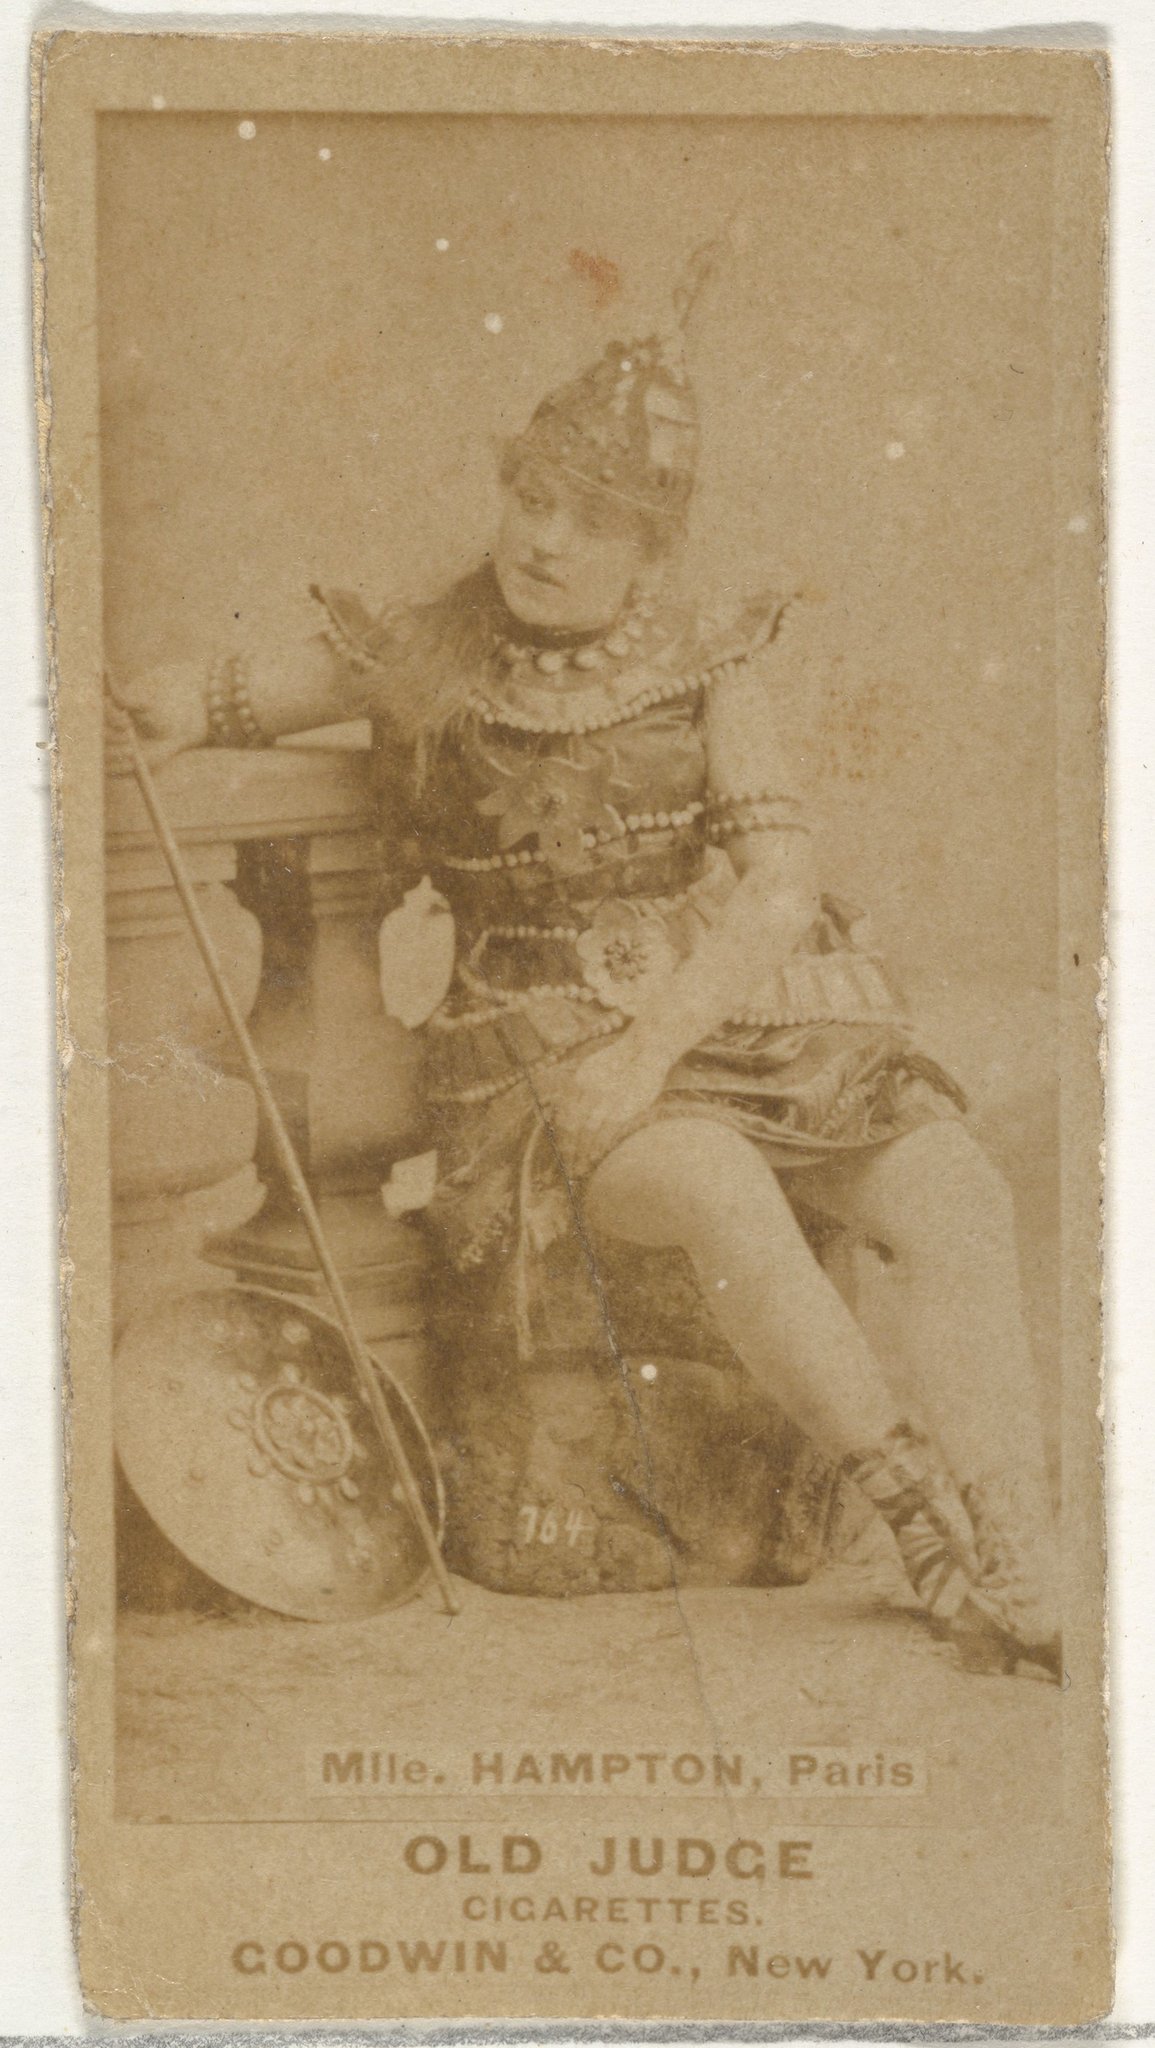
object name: photograph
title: Mlle. Hampton, Paris, from the Actors and Actresses series (N171) for Old Judge Cigarettes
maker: goodwin & company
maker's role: publisher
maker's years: 1850-1950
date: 1886-1890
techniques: albumen silver print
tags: portraits,women,actresses